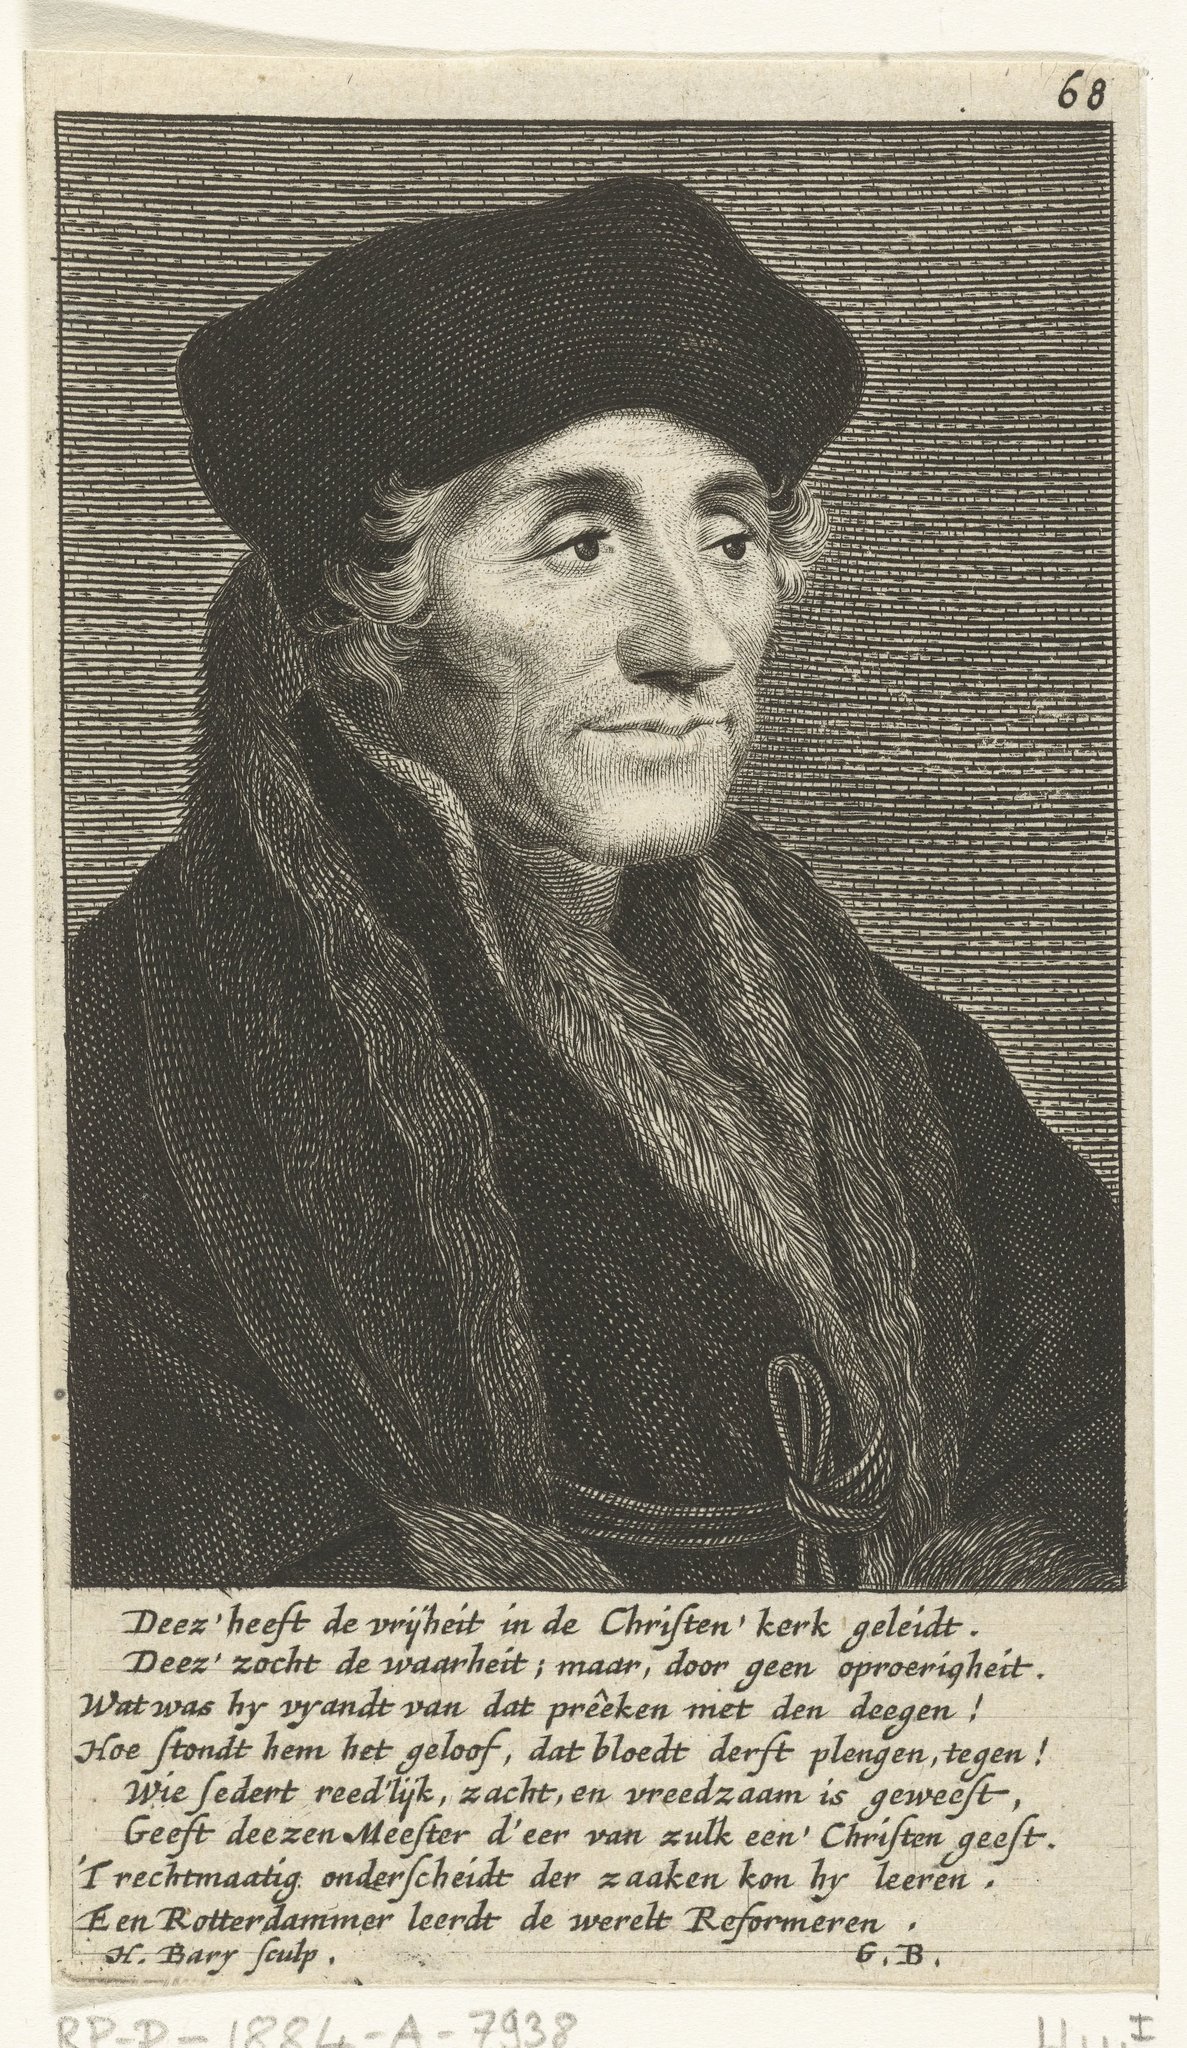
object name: book illustration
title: Portret van Desiderius Erasmus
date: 1657-1707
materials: paper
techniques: engraving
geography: netherlands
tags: desiderius erasmus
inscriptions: collector's mark: Lugt 2228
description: mogelijk boekillustratie voor G. Brandt, Verhaal van de reformatie, in en ontrent de Nederlanden. Amsterdam, voor J. Rieuwertsz, 1663